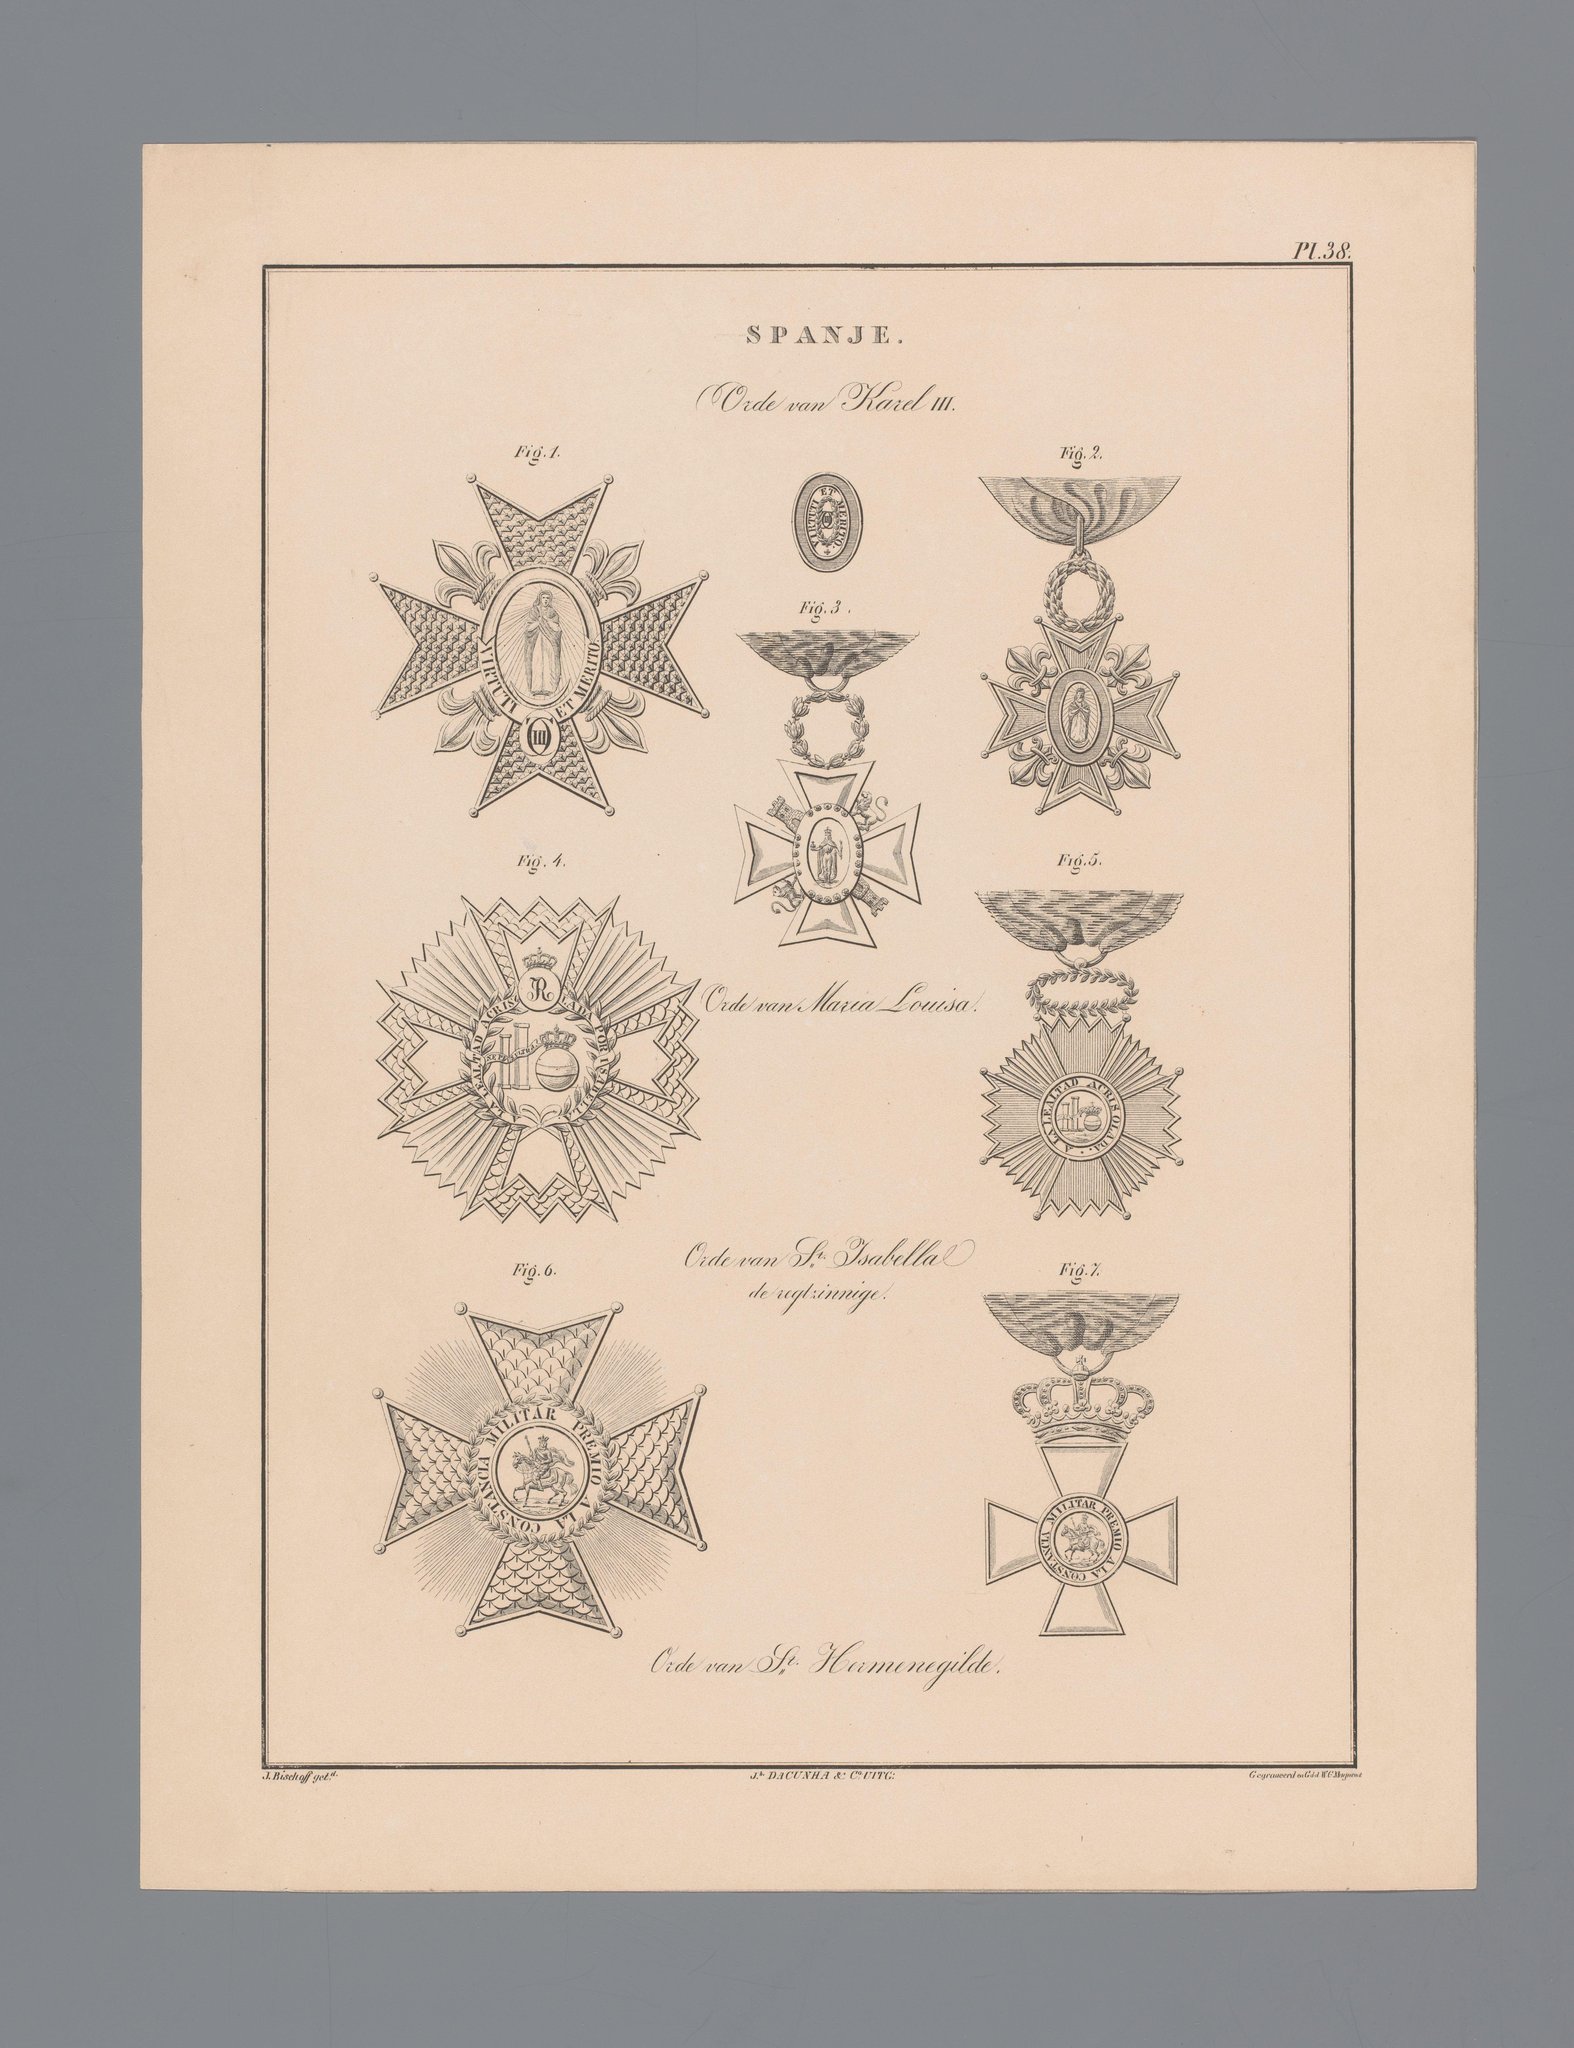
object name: print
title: Geschiedkundige beschrijving der oudere en nieuwere, thans bestaande ridderorden, zoo in als buiten Europa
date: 1843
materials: paper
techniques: lithograph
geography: amsterdam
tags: knighthood order, spain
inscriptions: collector's mark: Lugt 2228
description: Deze prent werd uitgegeven in: G.L. de Rochemont en J. Bischoff, Geschiedkundige beschrijving der oudere en nieuwere, thans bestaande ridderorden, zoo in als buiten Europa (...) Amsterdam, Jb. da Cunha & Co: 1843.